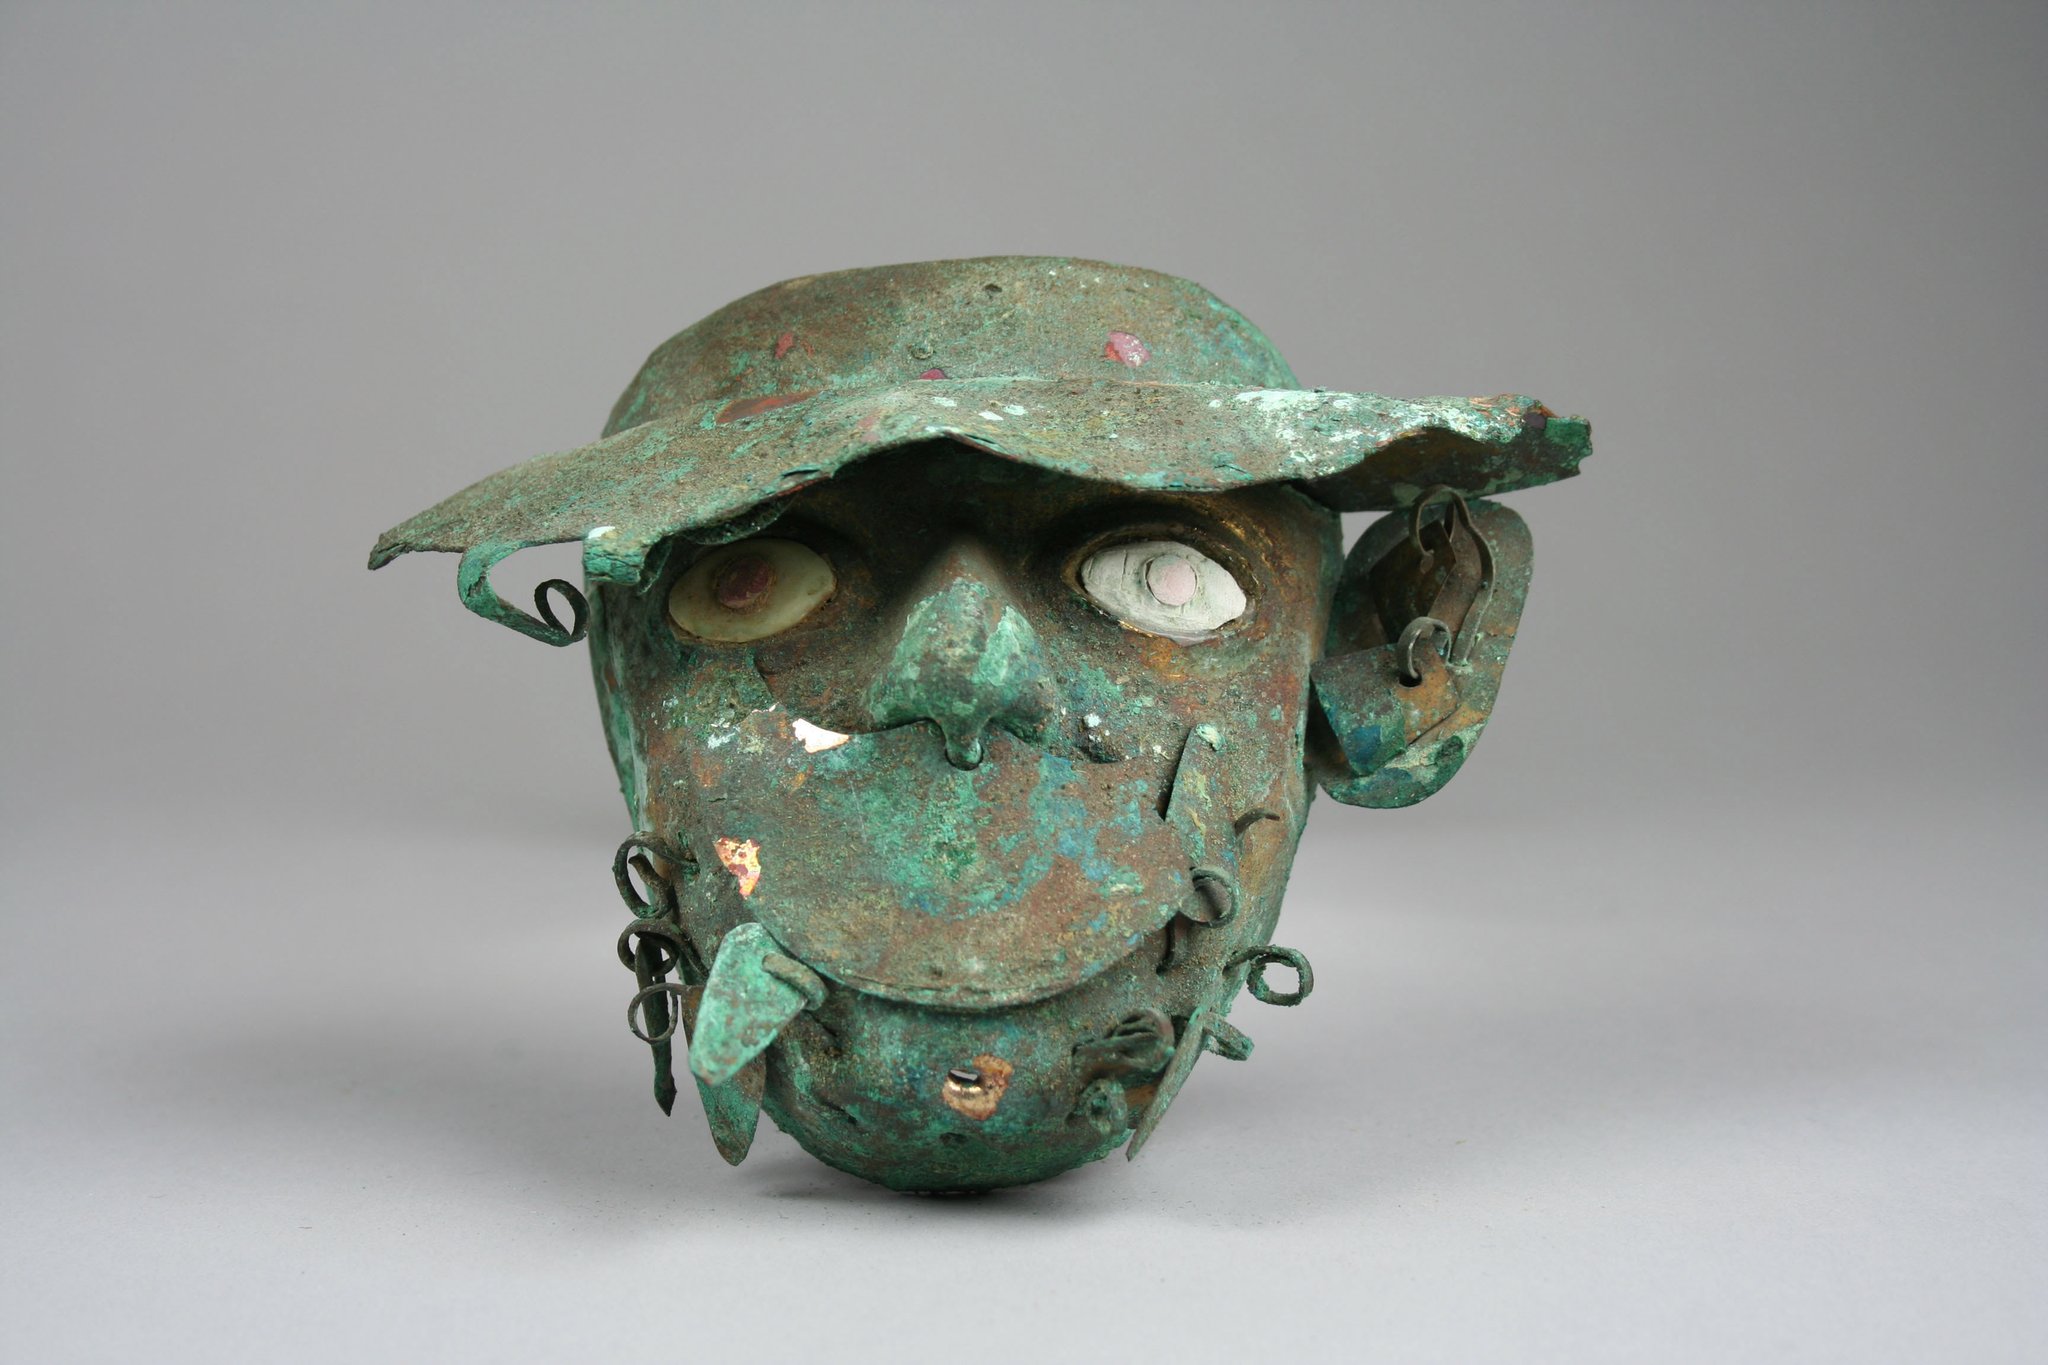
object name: ornament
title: Face Mask Ornament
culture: moche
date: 501-700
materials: gilt copper, shell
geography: peru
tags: faces